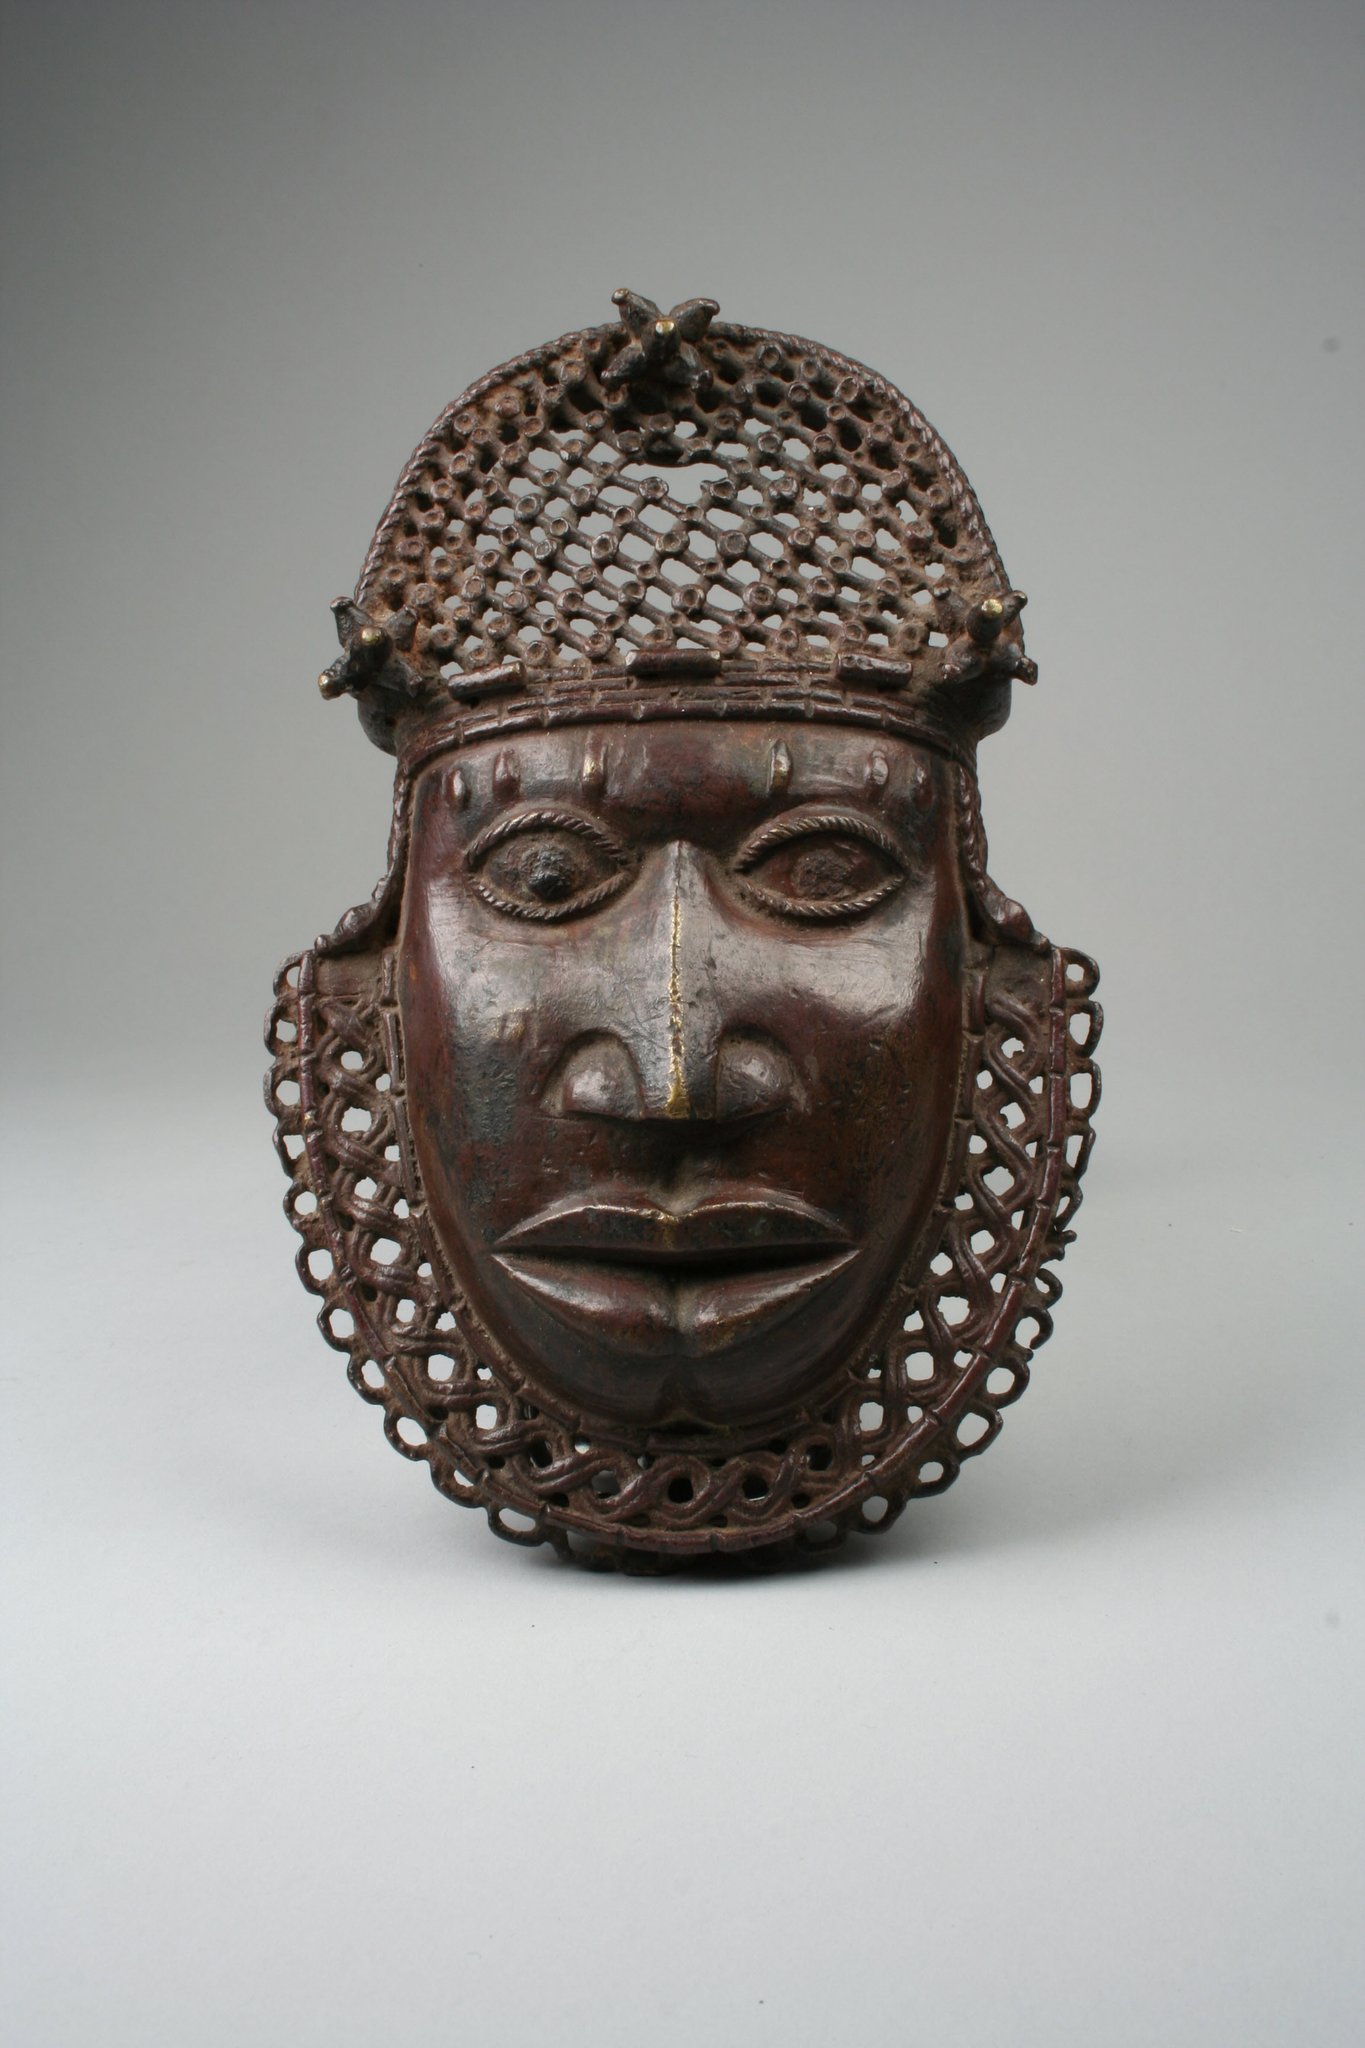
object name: ornament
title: Hip Ornament: Face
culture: edo period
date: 1501-1900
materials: brass, iron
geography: nigeria